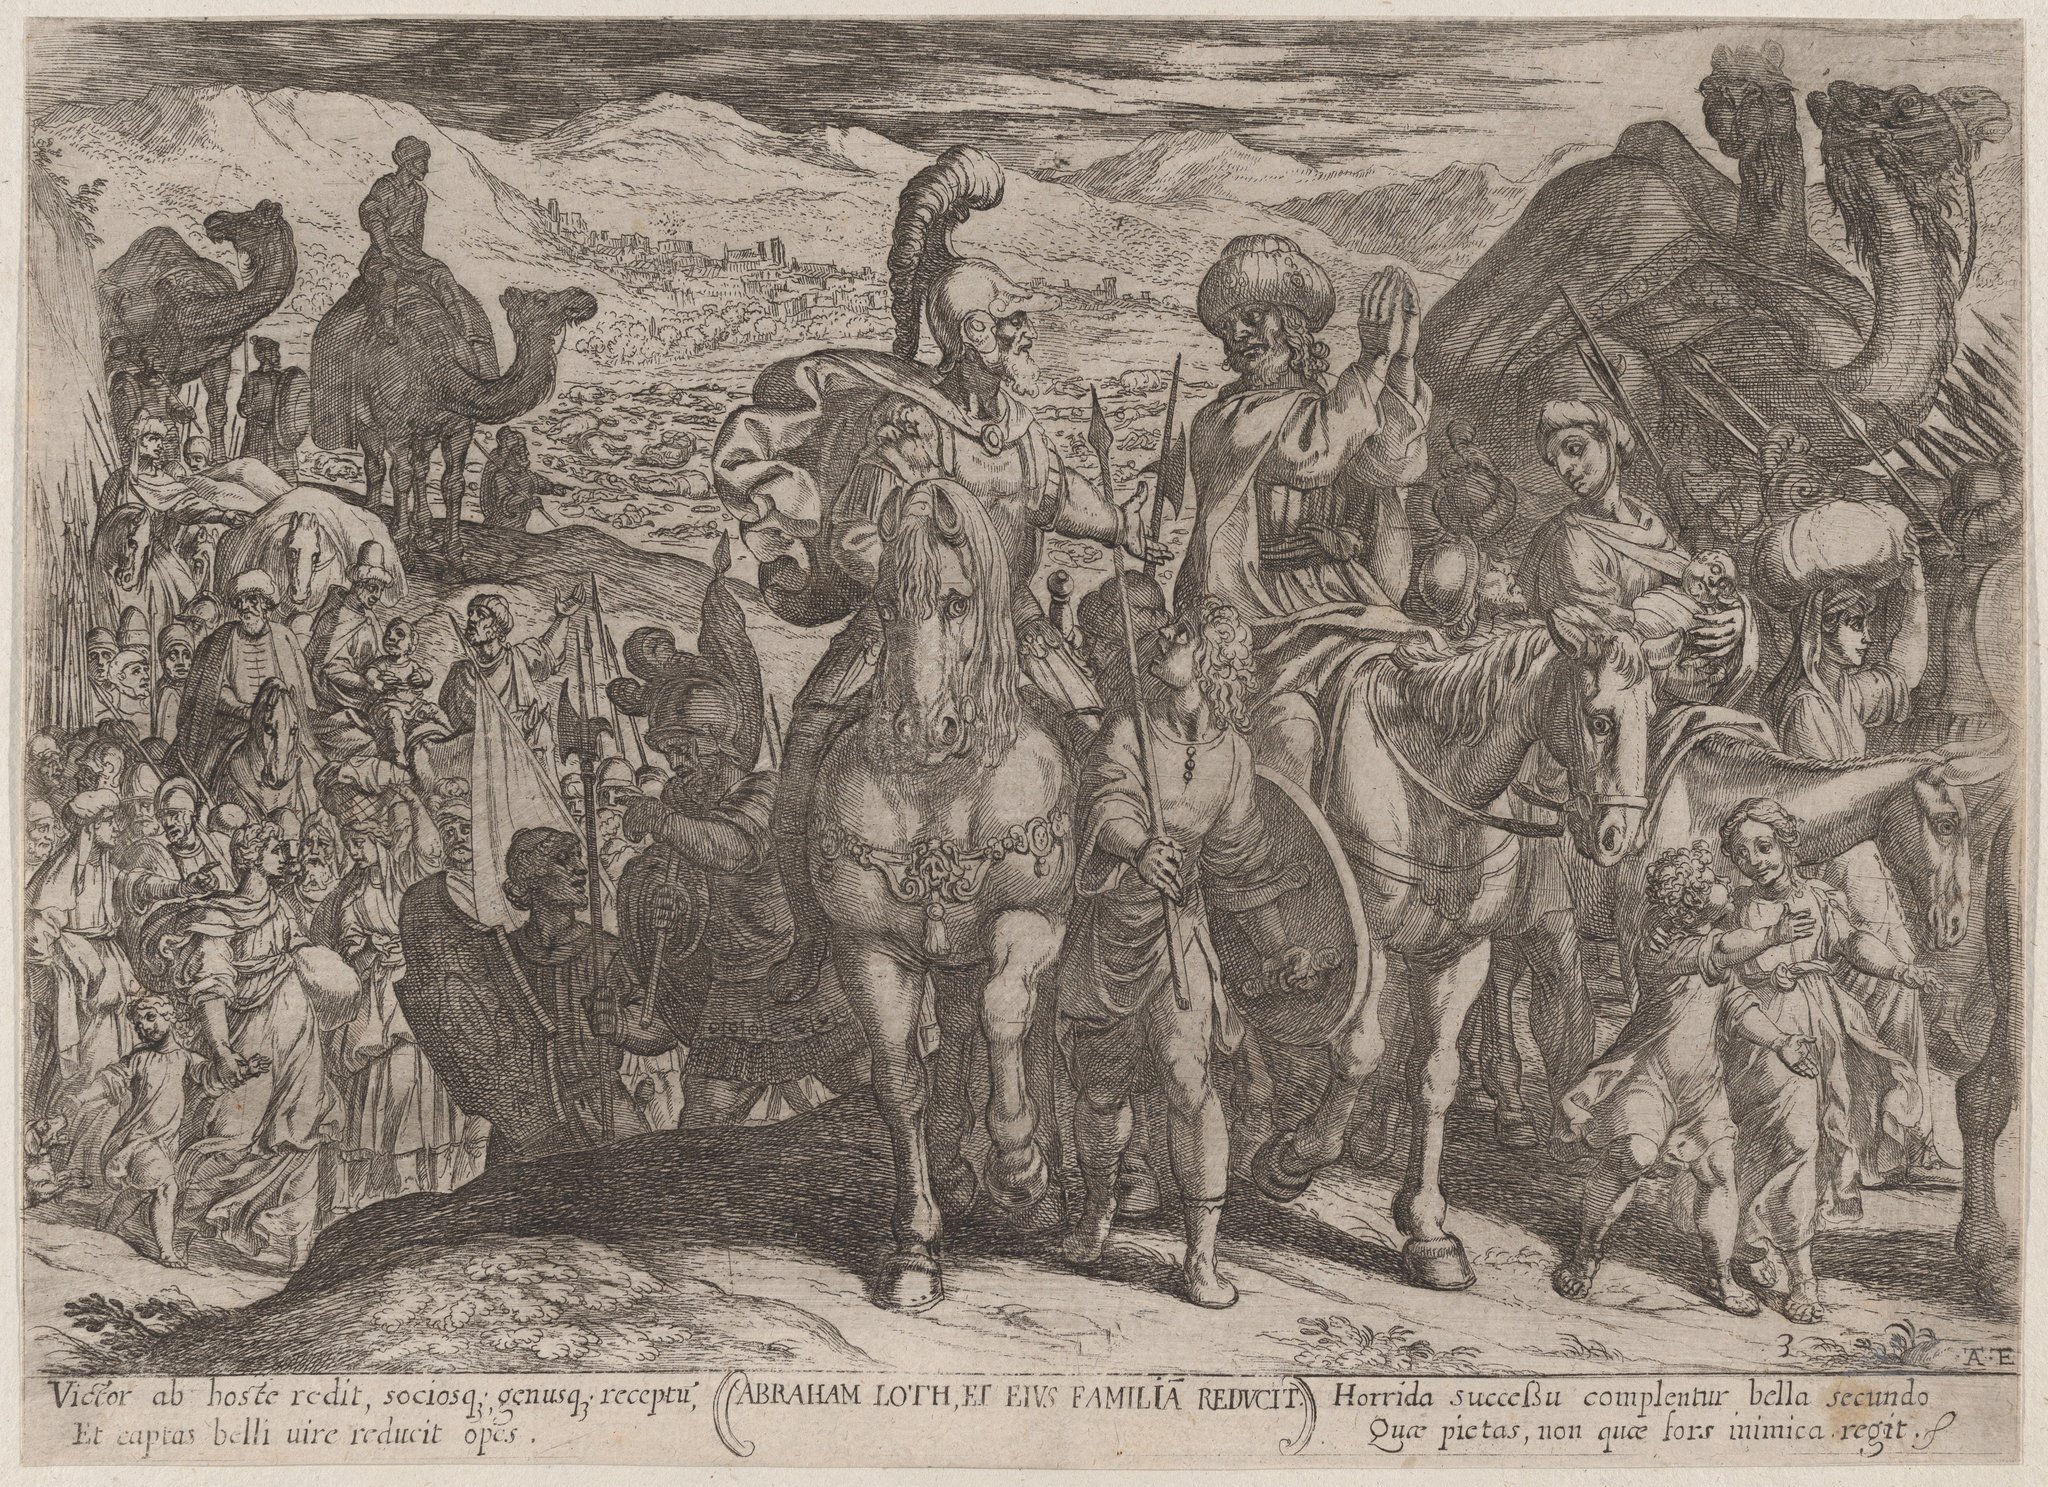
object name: print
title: Plate 3: Abraham Taking Lot and His Family to His Own Land, from "The Battles of the Old Testament"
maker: antonio tempesta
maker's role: artist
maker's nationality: italian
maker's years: 1555-1630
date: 1590-1610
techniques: etching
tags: men,camels,horses,abraham,family